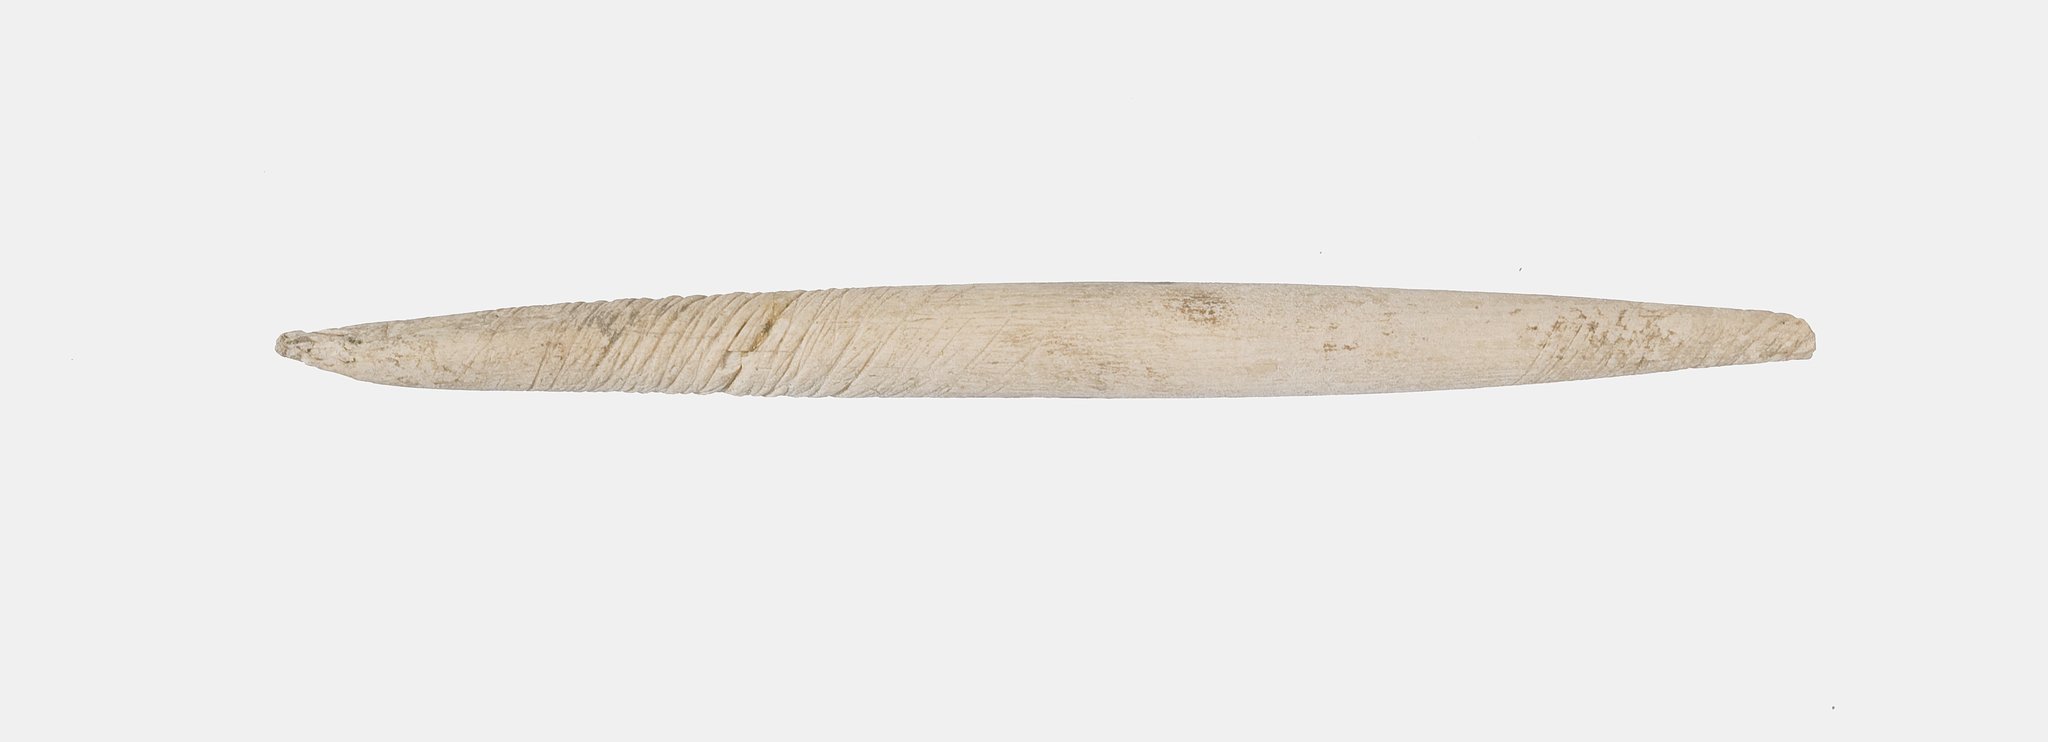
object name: weaving tool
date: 1295-1070 BCE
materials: bone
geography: egypt